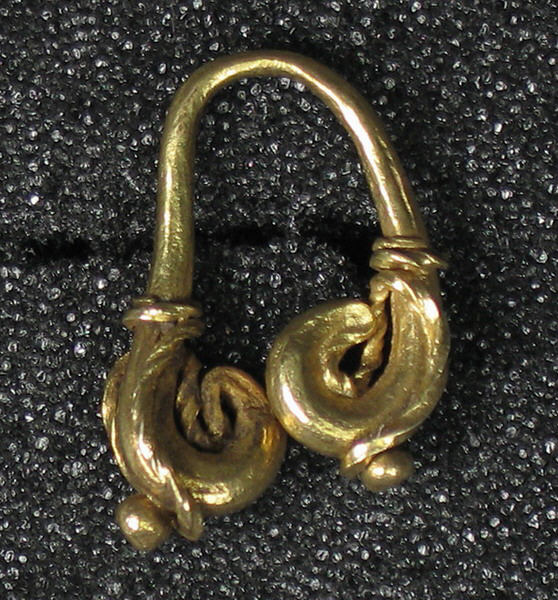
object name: ear ornament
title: Ear Ornament, Fertility Scroll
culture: indonesian, central java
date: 701-1200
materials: gold